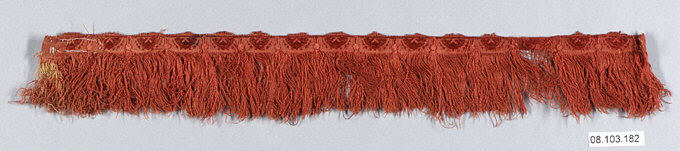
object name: fringe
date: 1801-1900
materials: silk